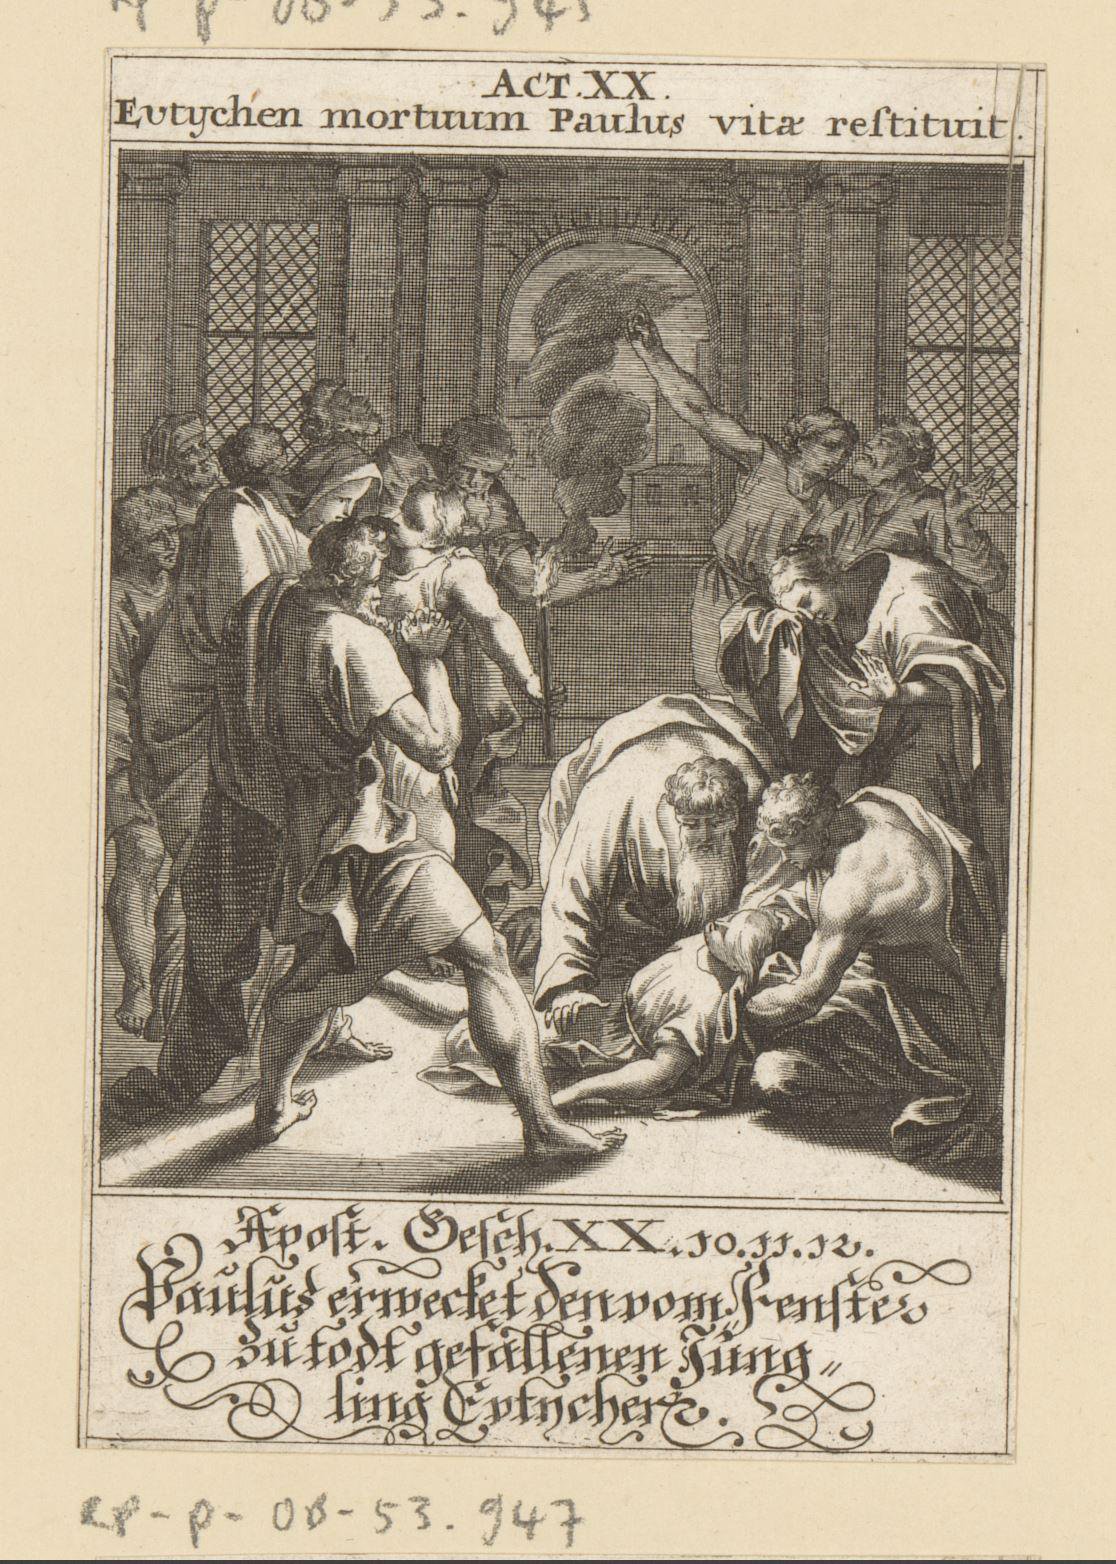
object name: print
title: Apostel Paulus wekt Eutychus tot leven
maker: Anonymous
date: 1697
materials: paper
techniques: etching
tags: eutychus is raised from the dead by paul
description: Prent ook gebruikt in: Biblia ectypa : Bildnussen auss Heiliger Schrifft. Regensburg: Chr. Wiegel, 1697.